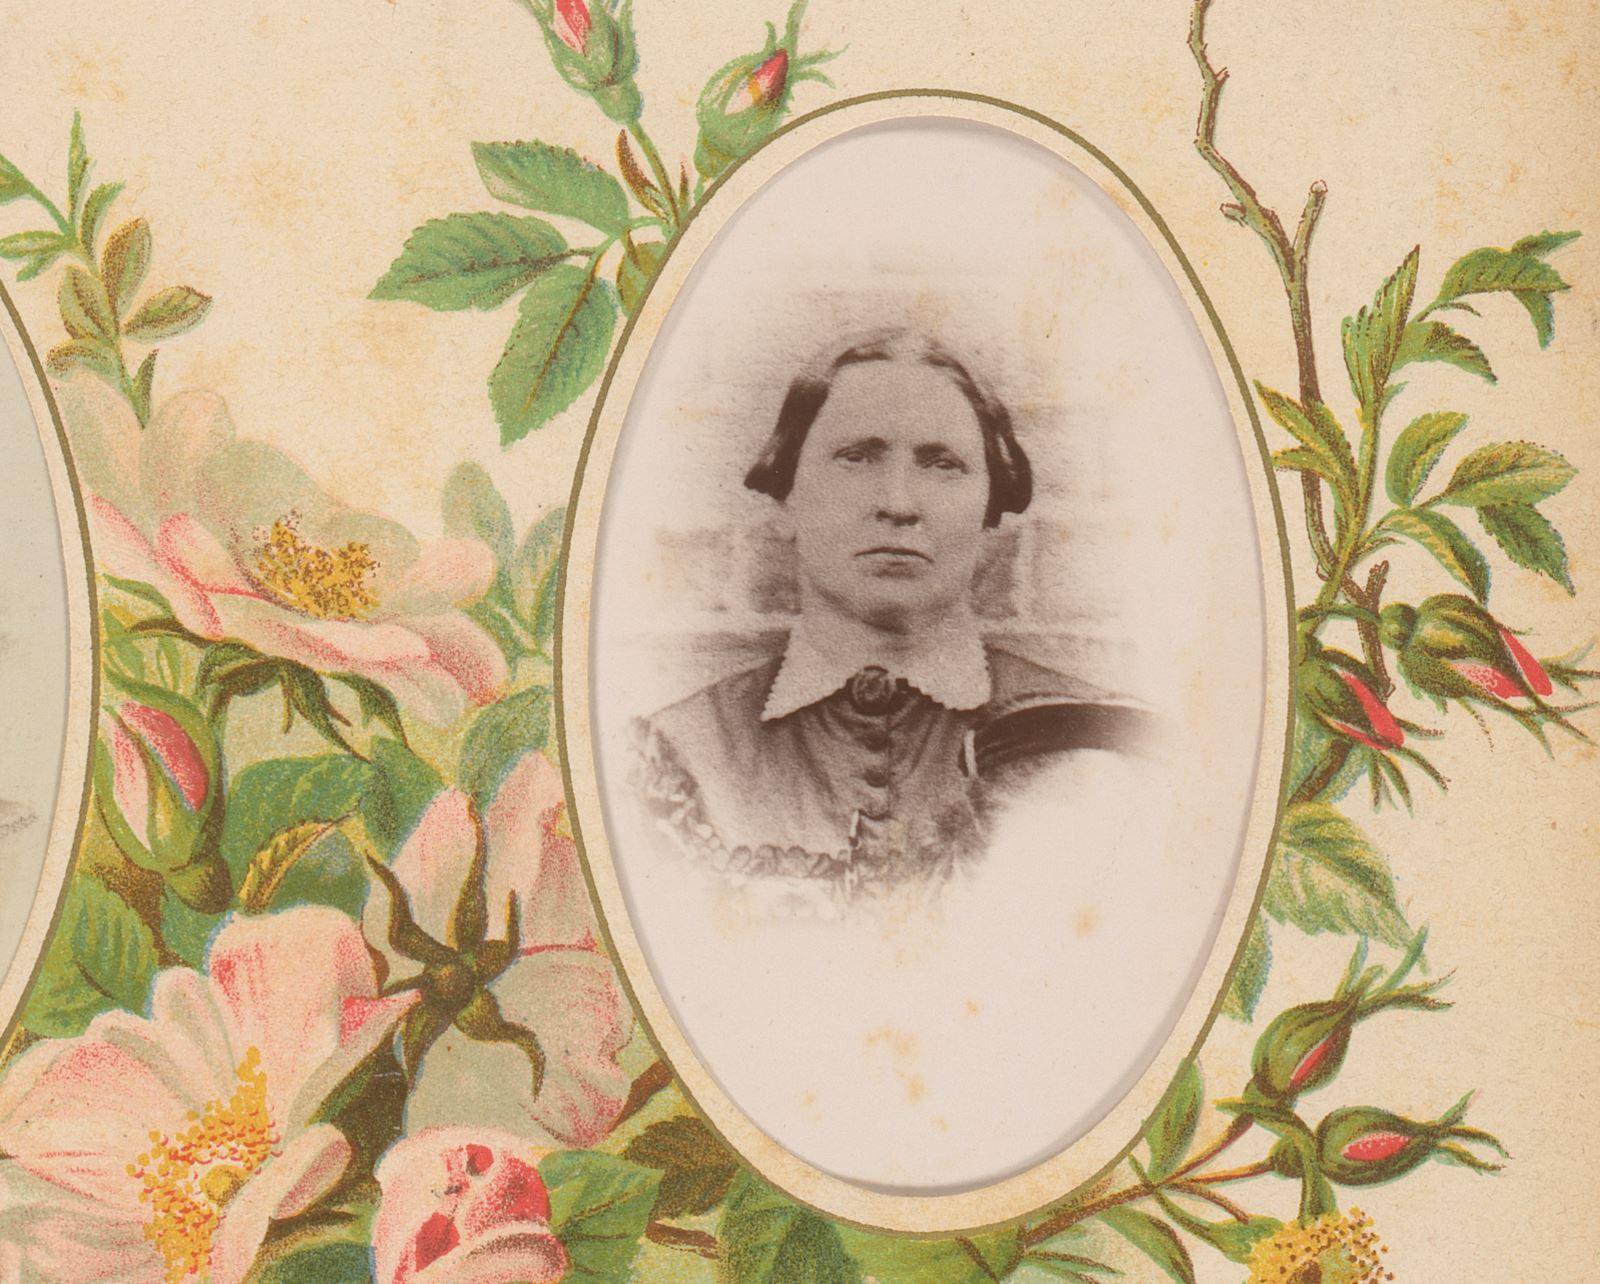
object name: photograph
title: Portret van een vrouw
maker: william seward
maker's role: fotograaf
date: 1860-1900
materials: cardboard, photographic support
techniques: albumen print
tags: adult woman, historical persons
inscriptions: inscription: ‘Photographer & Artist/ William Seward/ Pelham Street/ Nottingham/ (...)’